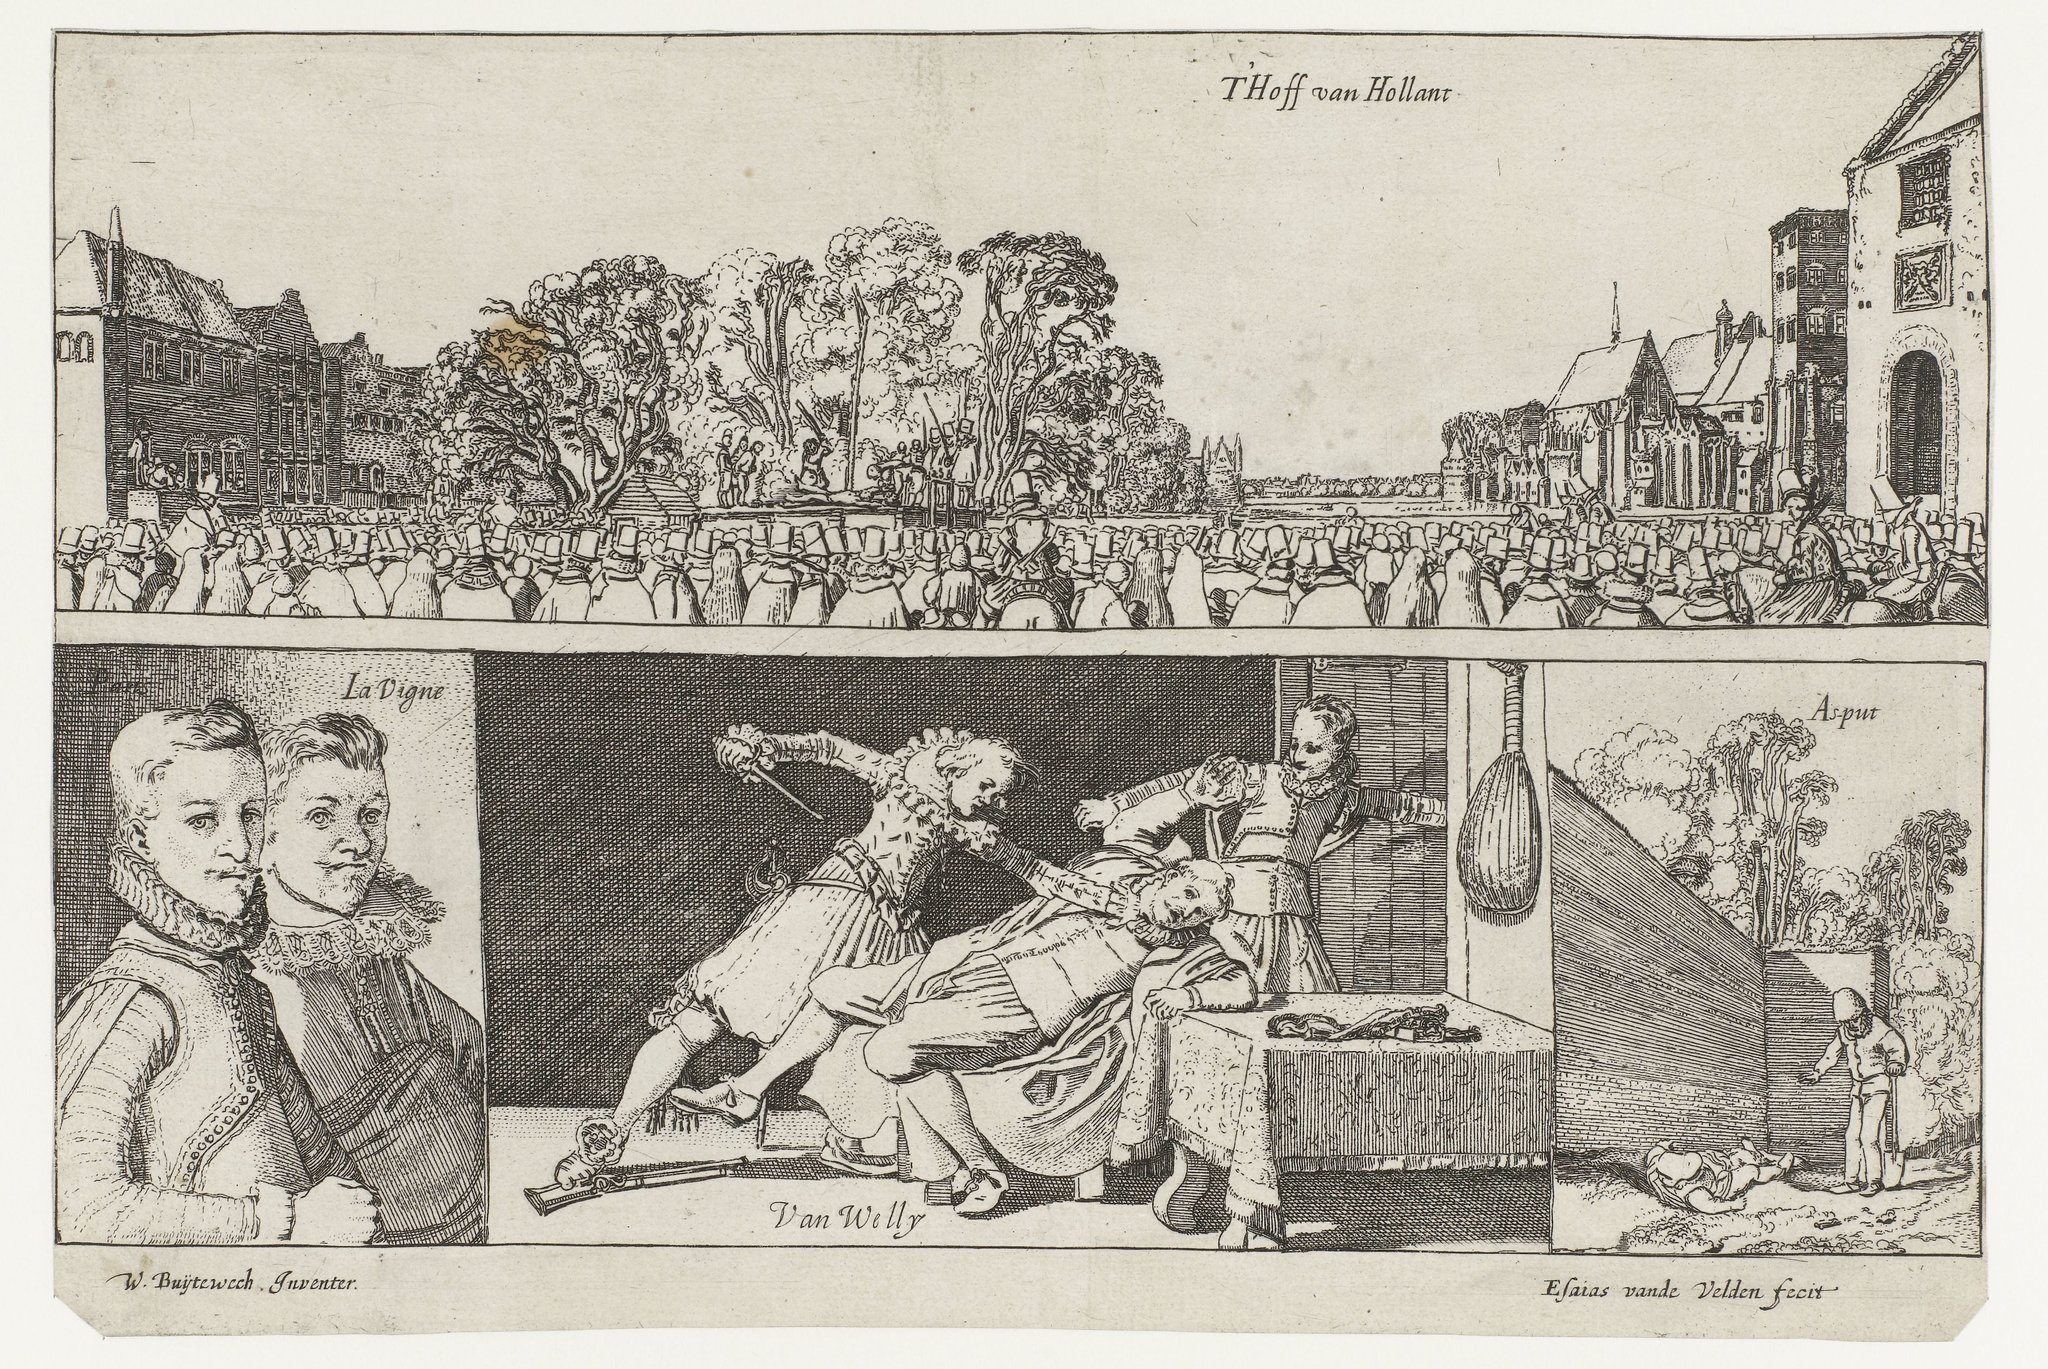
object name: print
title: Moord op Jan van Wely, juwelier te Amsterdam, 1616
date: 1616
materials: paper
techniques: engraving, etching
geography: northern netherlands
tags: the hague, maurice (prince of orange), murder, on the scaffold or place of execution, murderer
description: Moord op de door Maurits naar Den Haag ontboden Amsterdamse juwelier Jan van Wely, te Den Haag op 1 mei 1616. Blad met vier voorstellingen: middenonder de moord in het paleis van de prins, links de moordenaars Jan van Parijs en Jan de la Vigne, rechts de vinder van het lijk bij de tuinmuur. Bovenaan over de gehele breedte het radbraken van de moordenaars op het Groene Zoodje bij de Vijverberg te Den Haag.